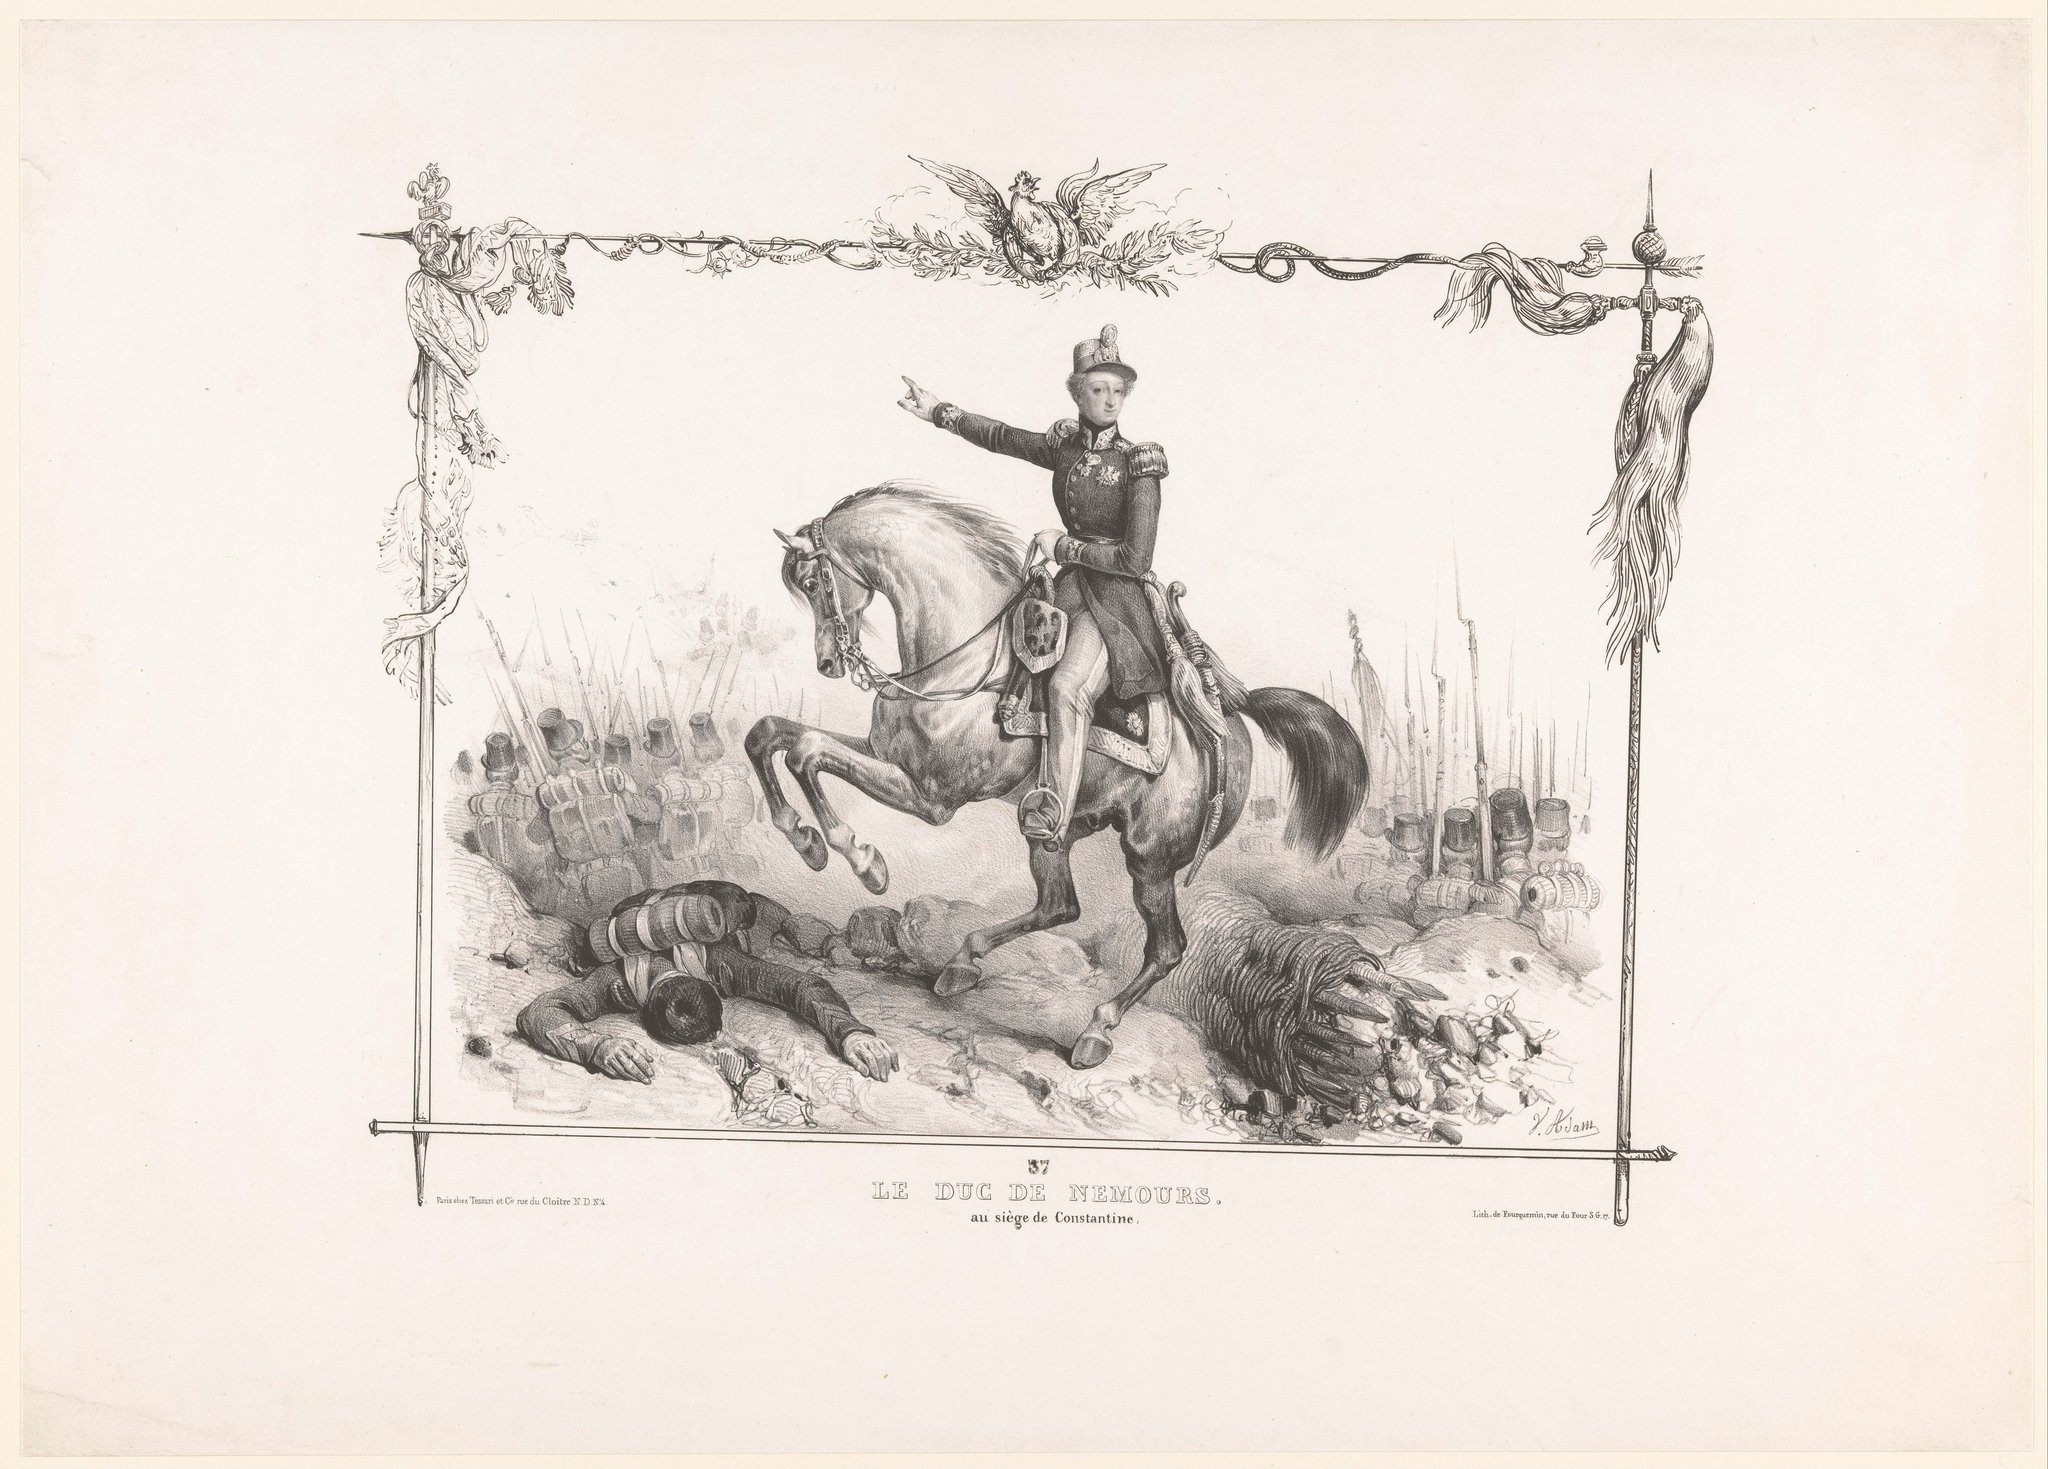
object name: print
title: Le Duc de Nemours au siège de Constantine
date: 1838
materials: paper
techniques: lithograph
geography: paris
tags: paris, riding a horse, ass, or mule; rider, horseman, siege, position war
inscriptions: collector's mark: Lugt 2228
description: Lodewijk van Orléans, de hertog van Nemours, zit te paard tijdens het beleg van Constantine in Algerije (1837).